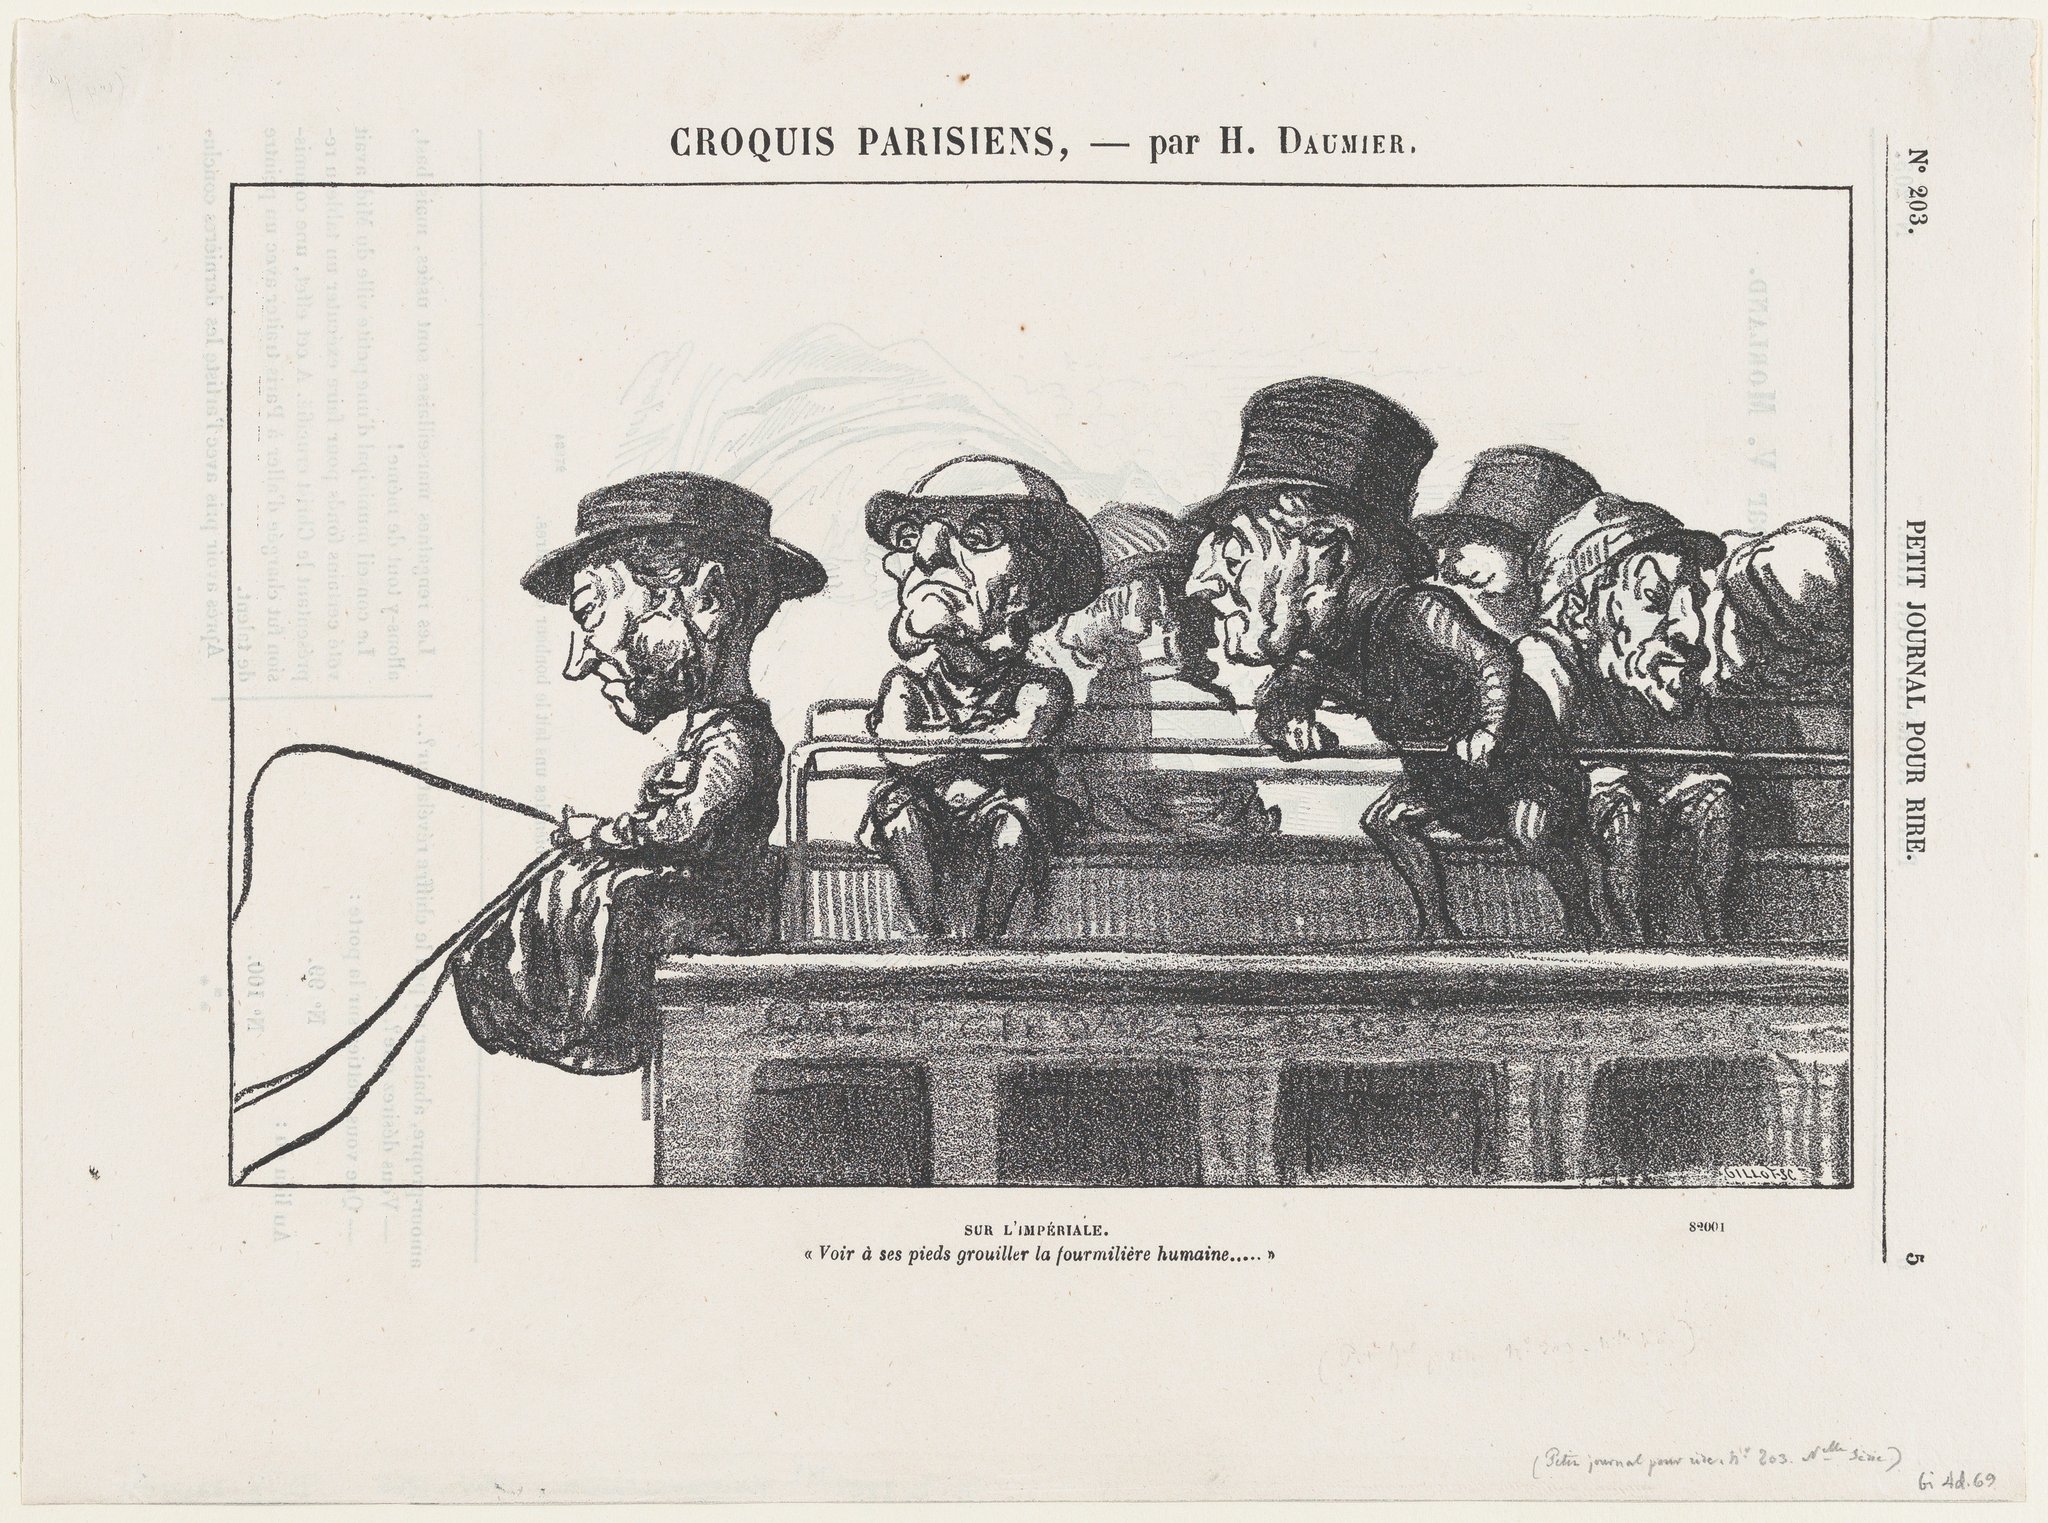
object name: print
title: On the imperiale, "At one's feet one can observe the swarming of a human ant-hill," from 'Parisian sketches,' published in Le Petit Journal pour Rire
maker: honoré daumier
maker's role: artist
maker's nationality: french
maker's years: 1808-1879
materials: paper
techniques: lithograph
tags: satire,men